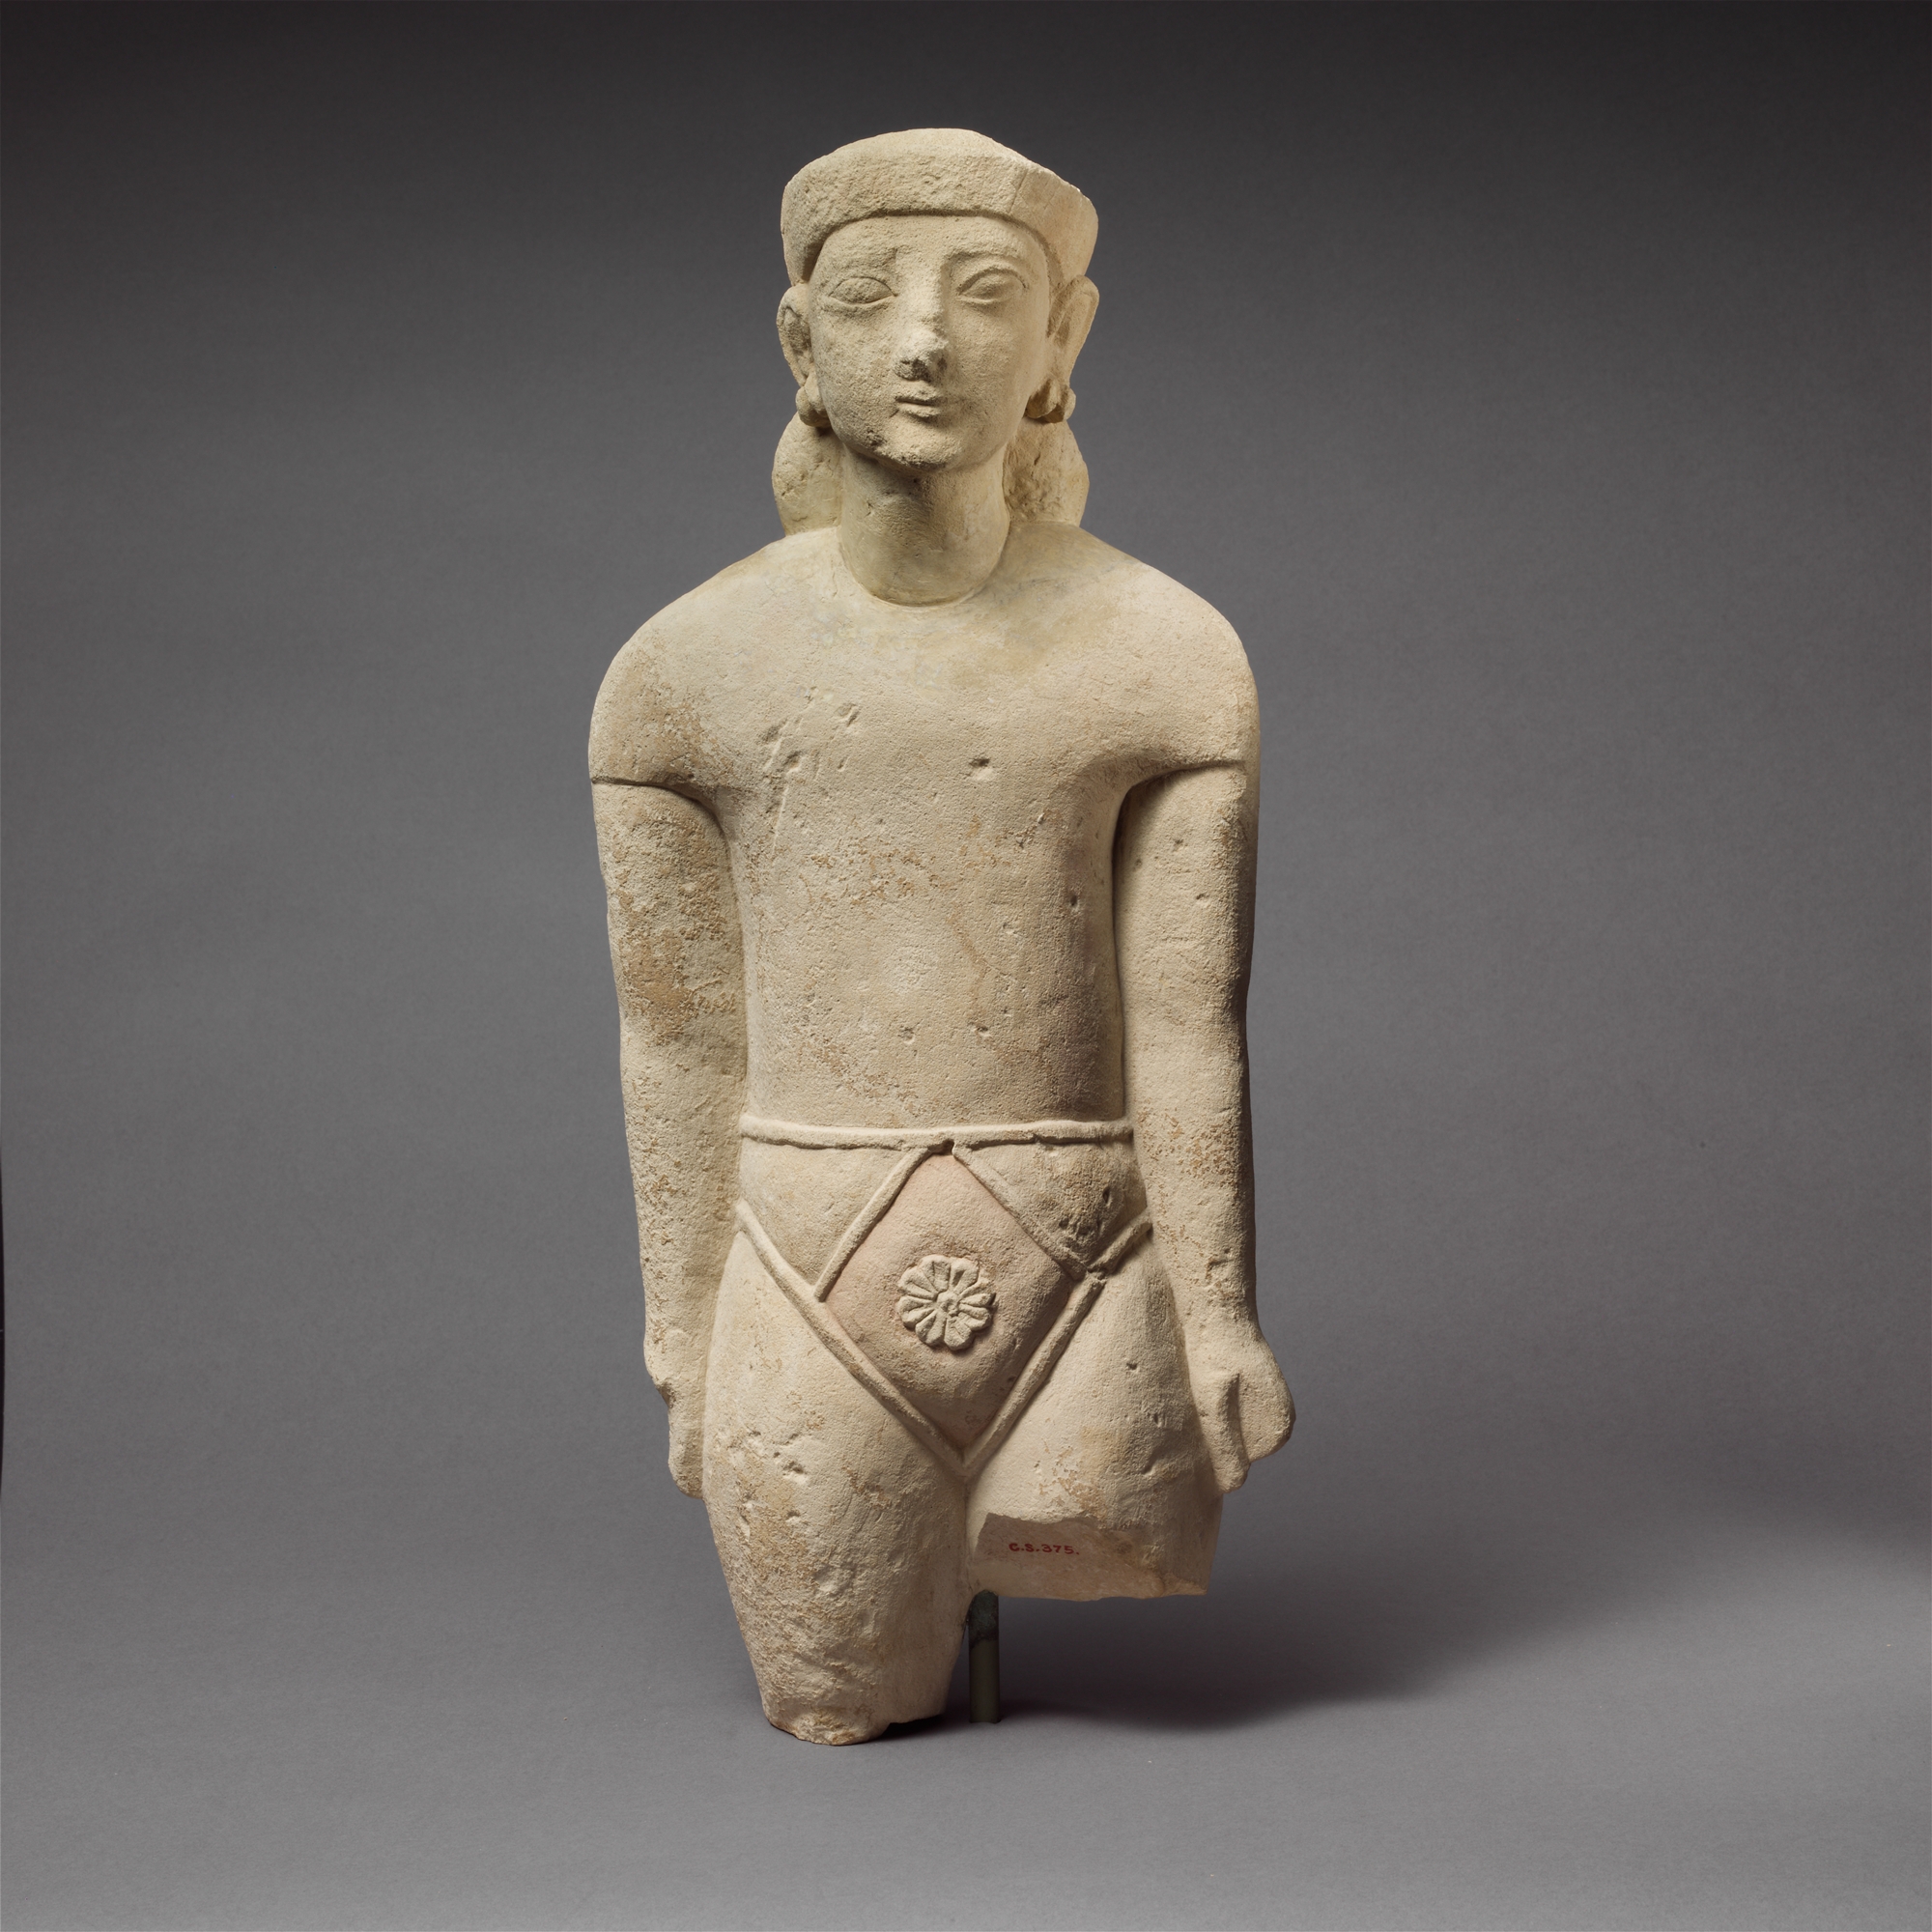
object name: statue of a votary, male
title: Limestone statuette of a male votary with Cypriot shorts and a diadem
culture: cypriot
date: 600-551 BCE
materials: limestone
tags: men